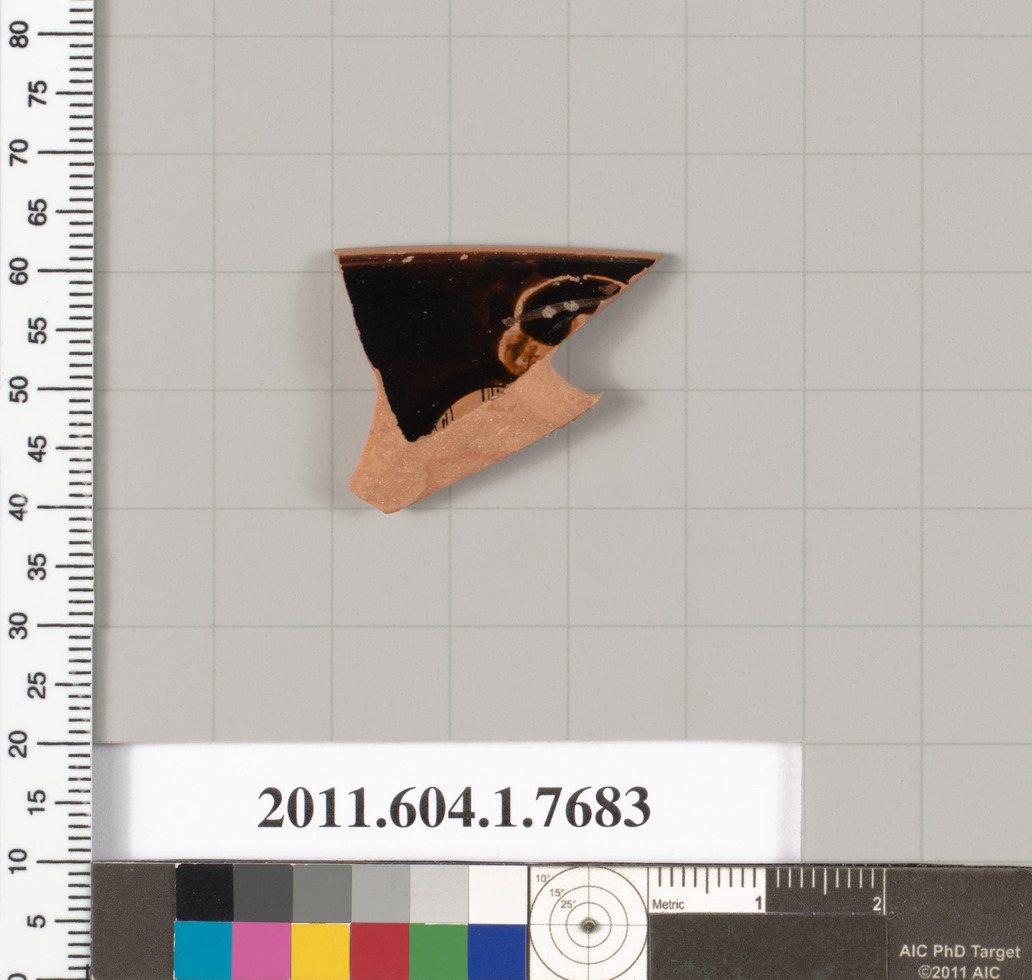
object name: kylix fragment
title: Terracotta rim fragment of a kylix (drinking cup)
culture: greek, attic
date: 460-450 BCE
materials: terracotta